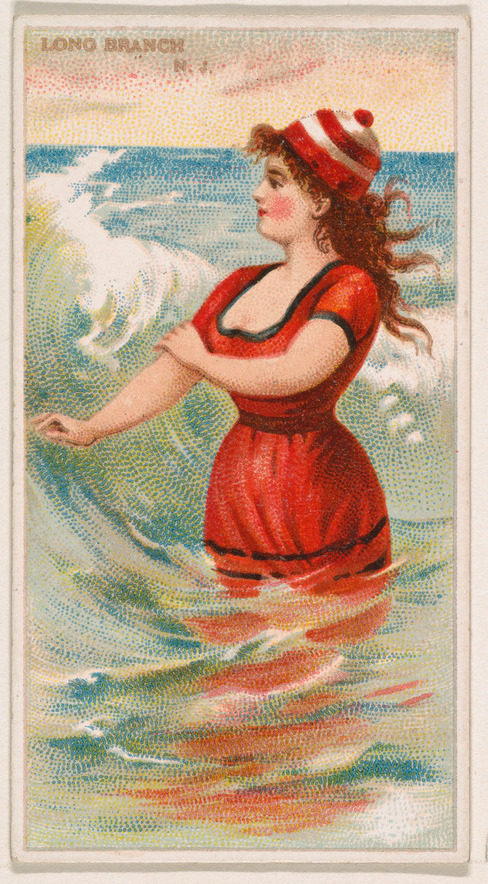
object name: print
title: Long Branch, New Jersey, from the Surf Beauties series (N232), issued by Kinney Bros.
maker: kinney brothers tobacco company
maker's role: publisher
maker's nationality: american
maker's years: 1869-2011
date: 1889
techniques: color lithograph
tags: profiles,women